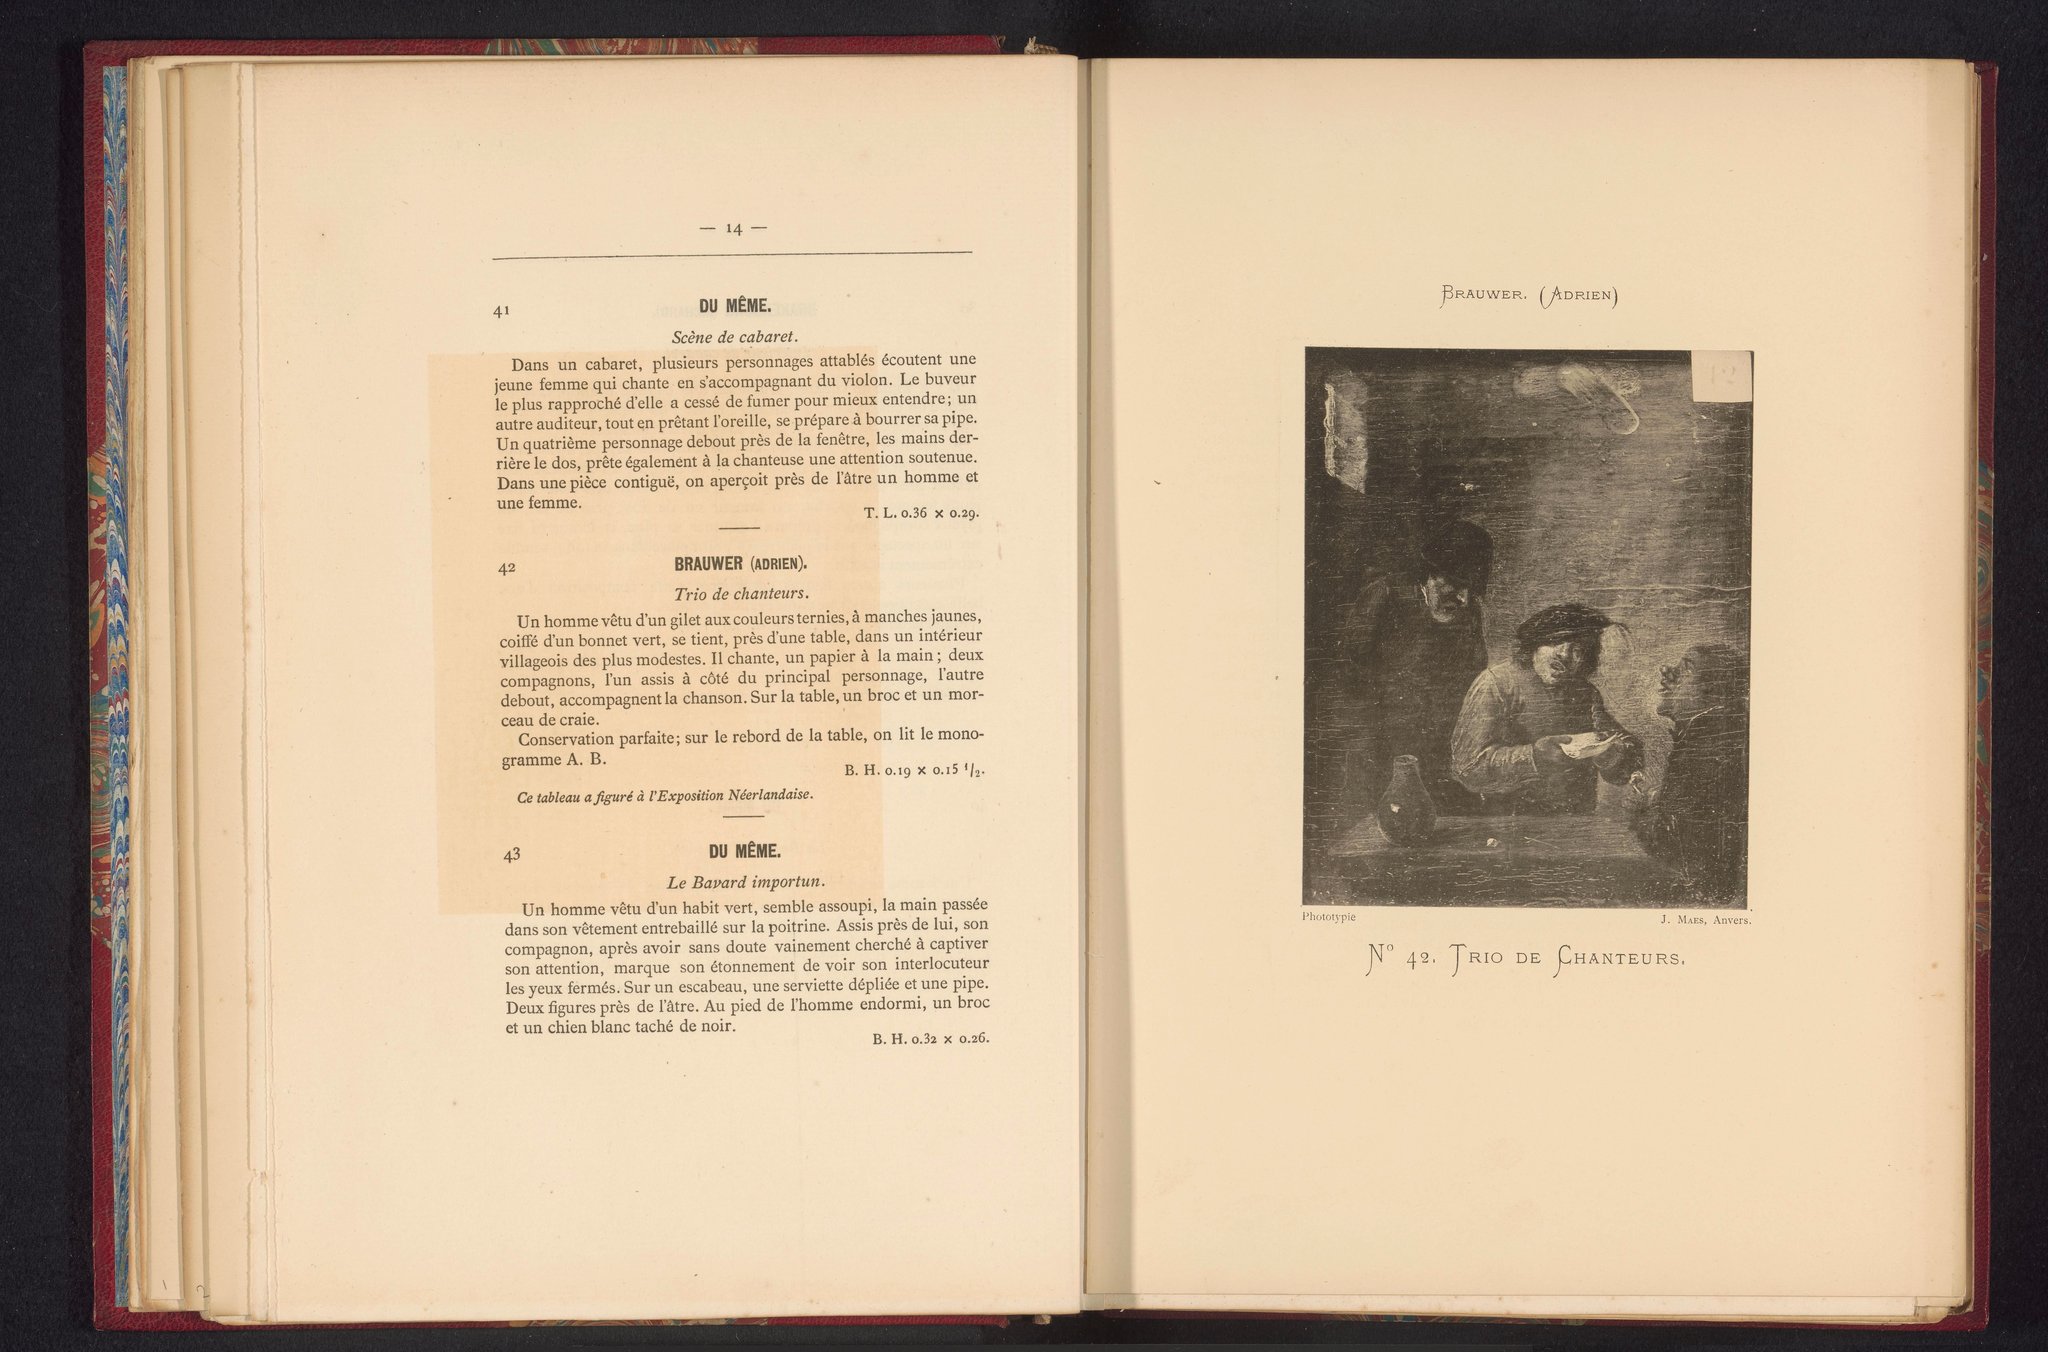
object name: photomechanical print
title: Reproductie van een schilderij van drie onbekende mannen aan een tafel van Adriaen Brouwer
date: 1878-1883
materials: paper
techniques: photograph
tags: adult man, historical persons, painting, drawing and the graphic arts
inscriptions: number: ‘No. 42’